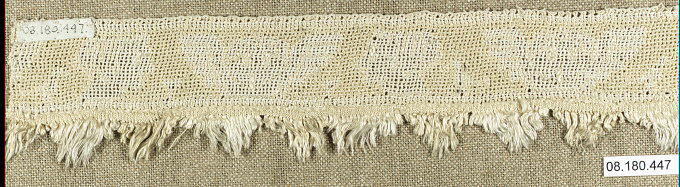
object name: border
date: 1501-1600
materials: silk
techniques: embroidery